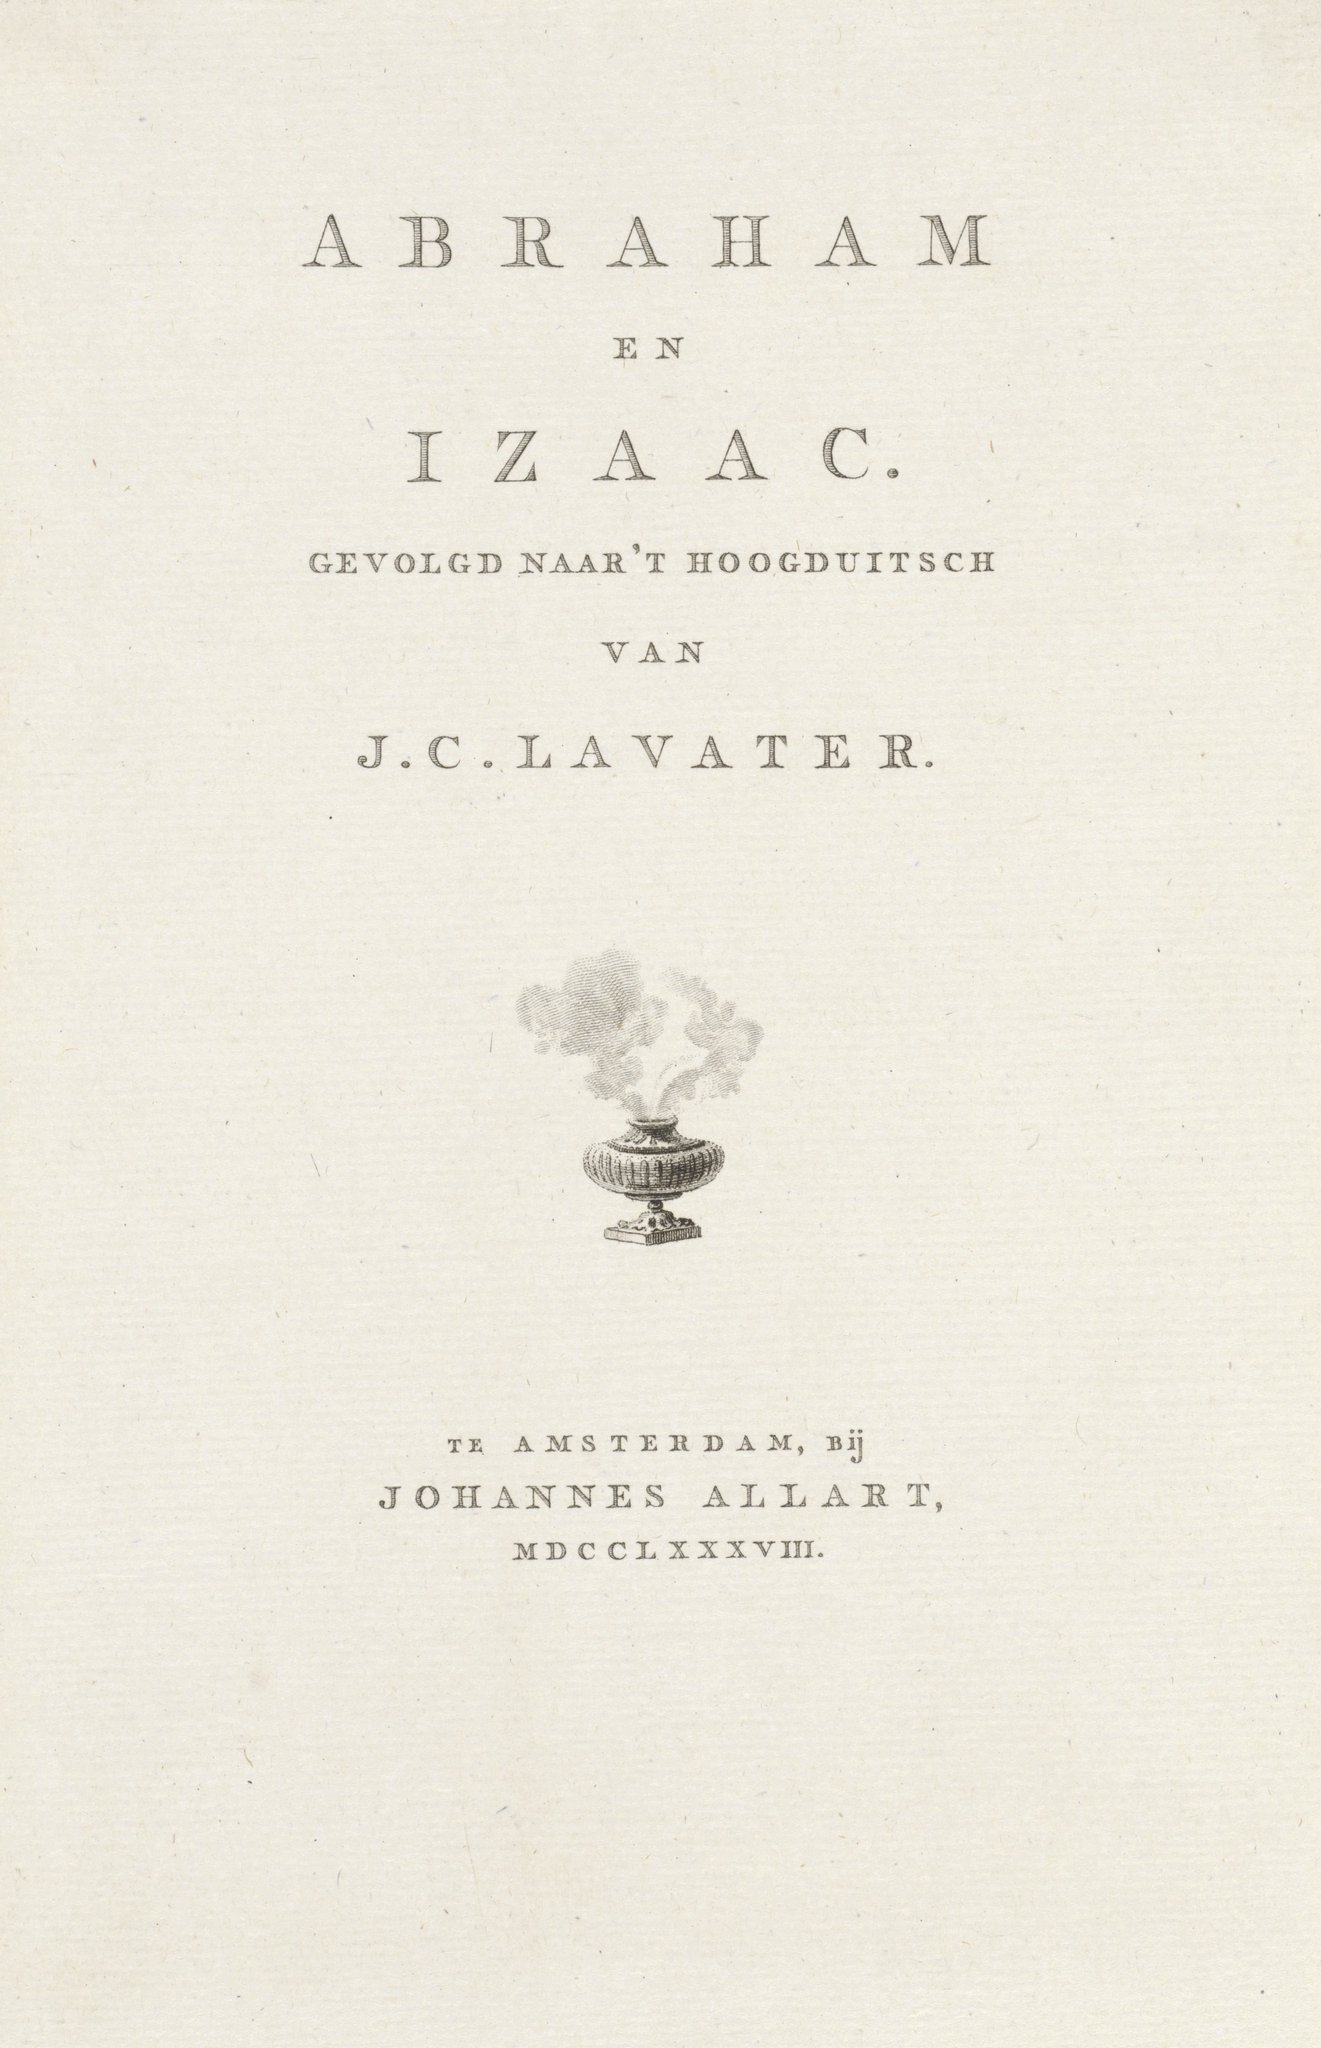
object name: print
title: Titelpagina voor: J.C. Lavater 'Abraham en Izaac', 1788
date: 1788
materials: paper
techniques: etching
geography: amsterdam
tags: incense-burner ~ scents, perfumes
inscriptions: collector's mark: Lugt 240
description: Titelpagina voor: Lavater, J.C. Abraham en Izaac. Amsterdam: Johannes Allart, 1788.